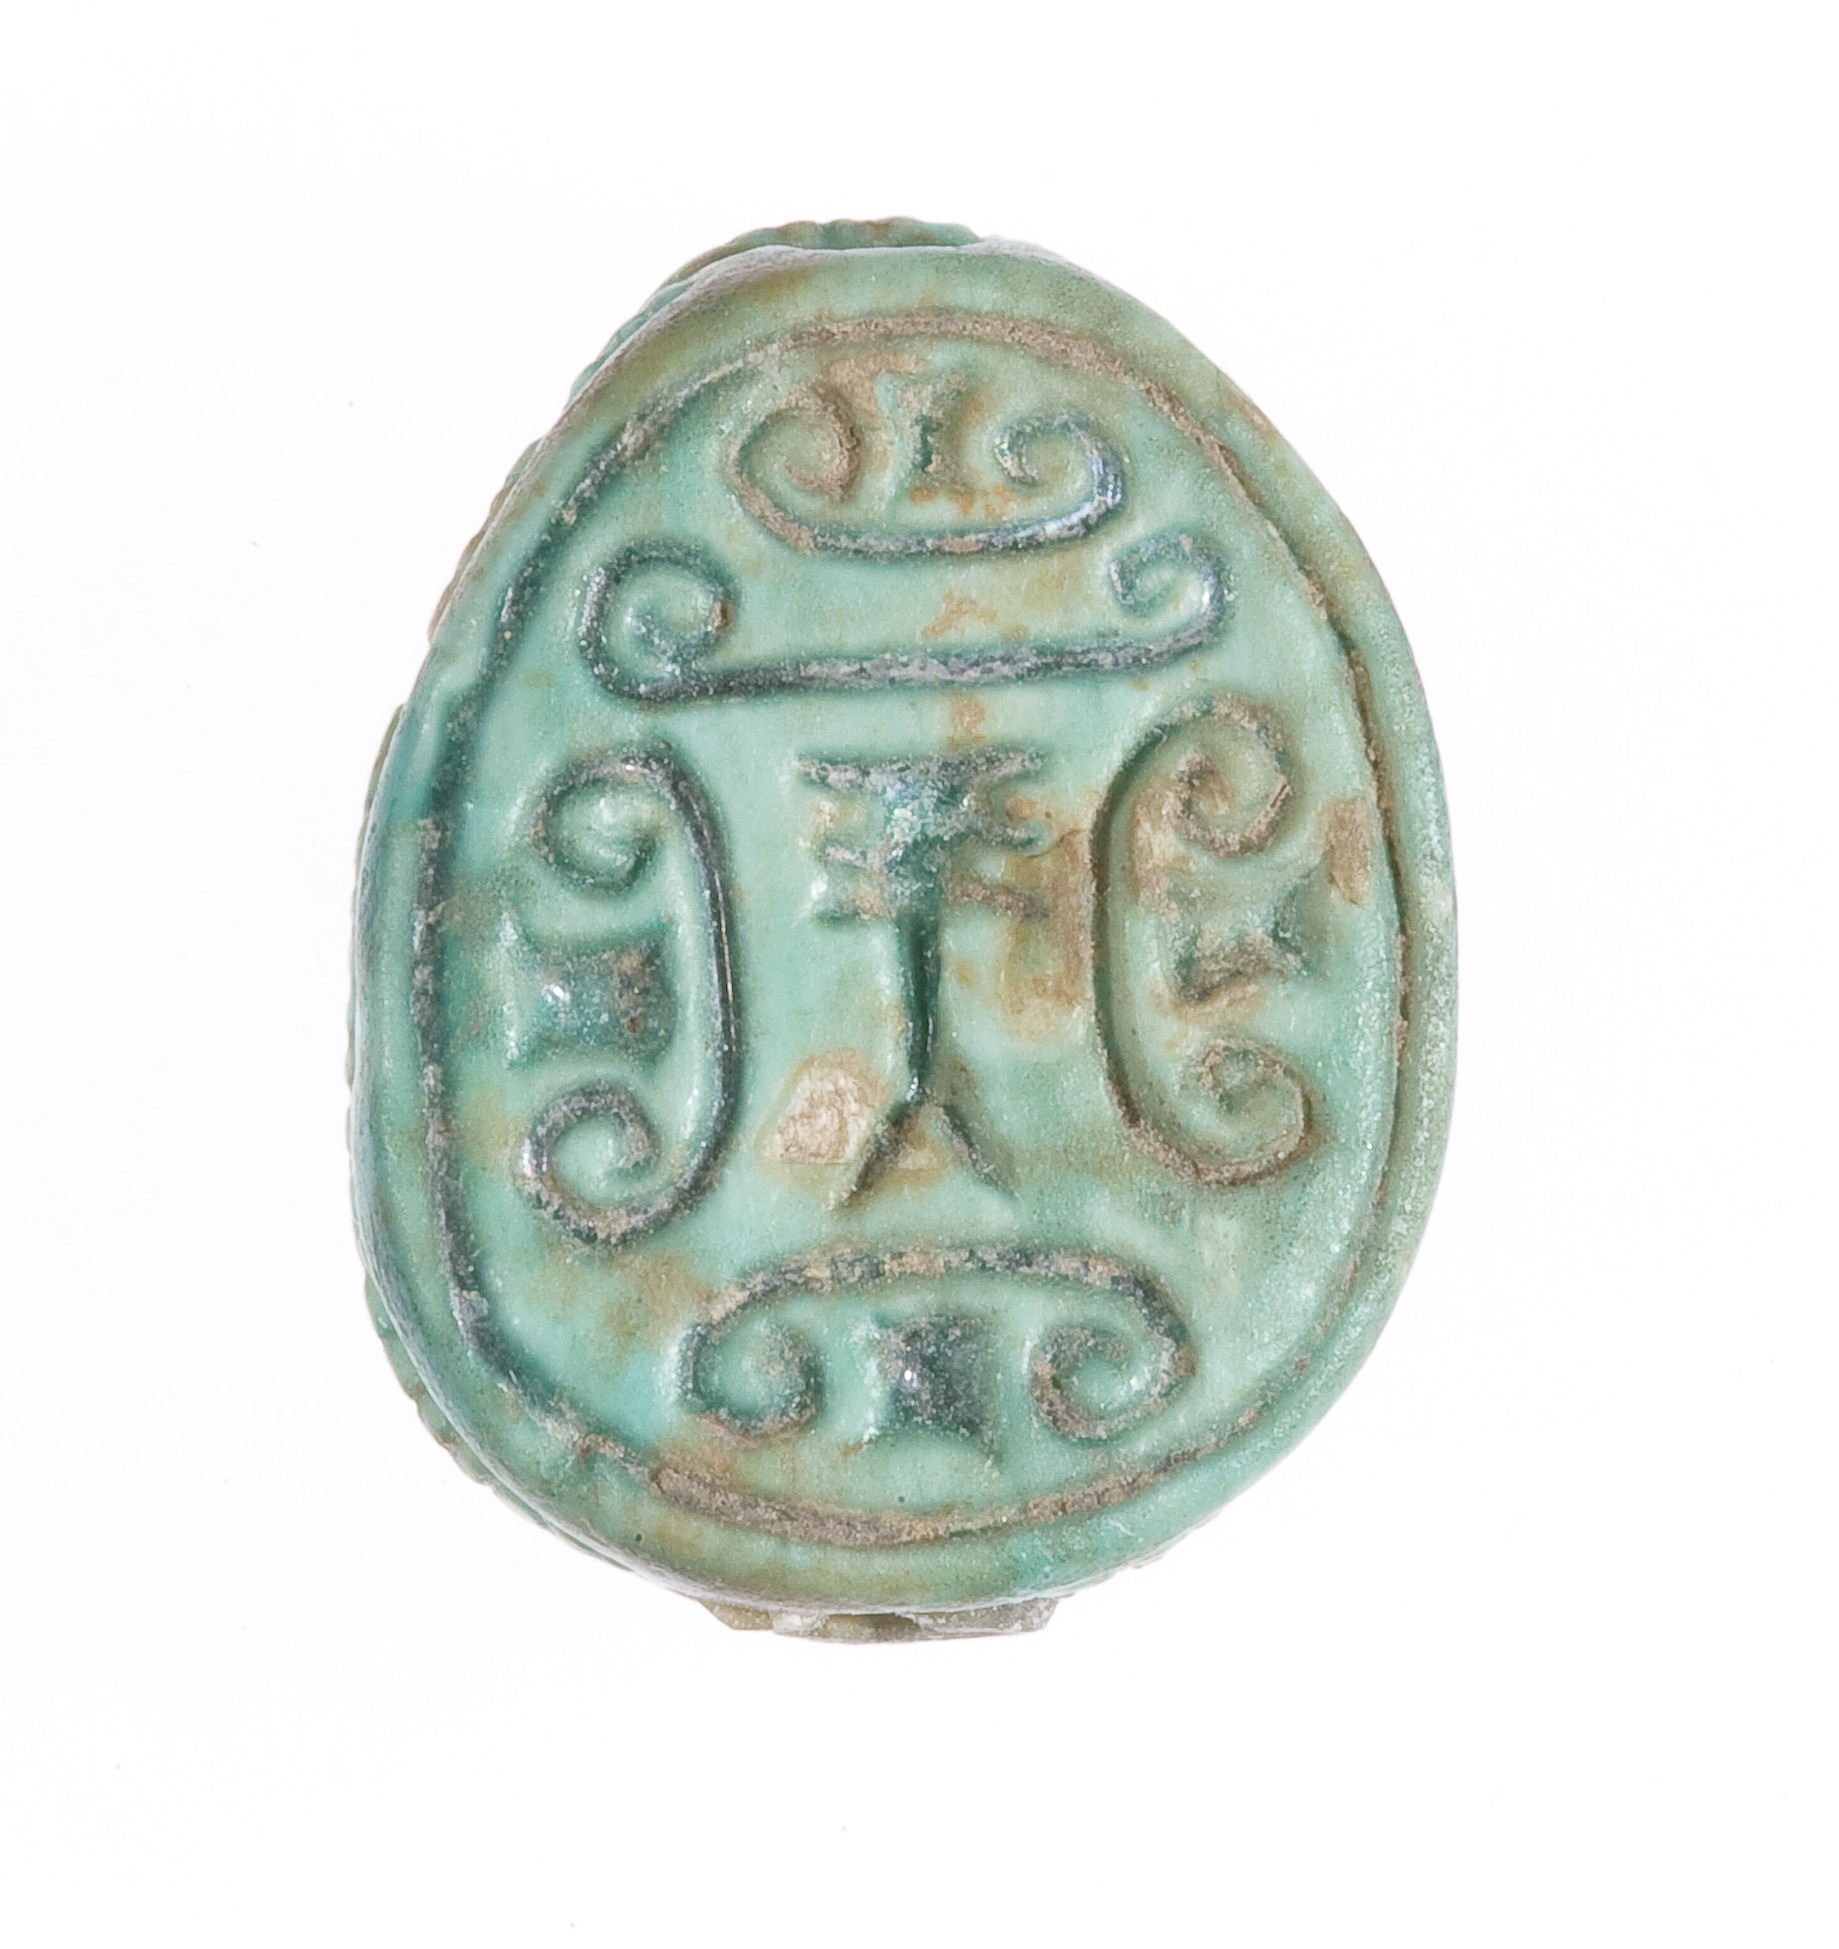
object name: scarab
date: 1550-1458 BCE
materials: stone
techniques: glazing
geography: egypt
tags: scarabs